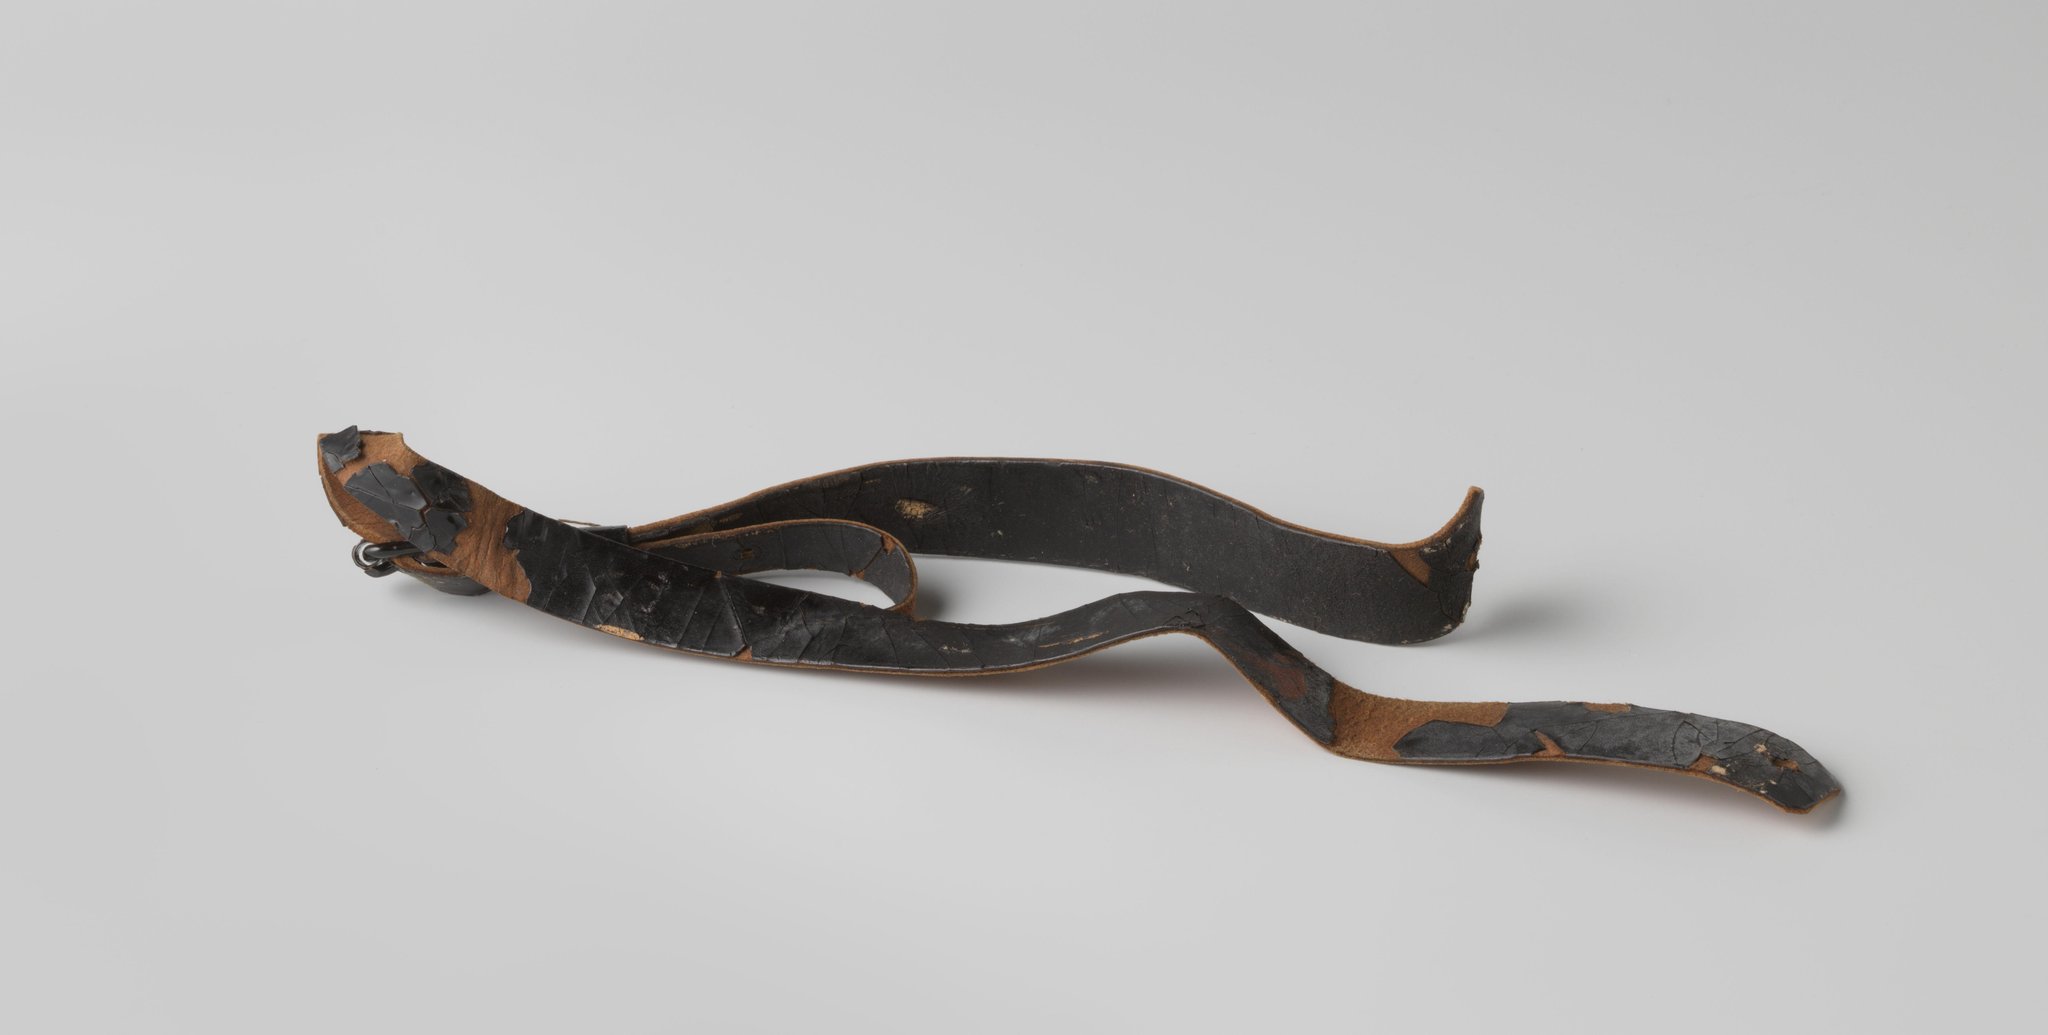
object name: uniform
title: Riem horende bij een sjako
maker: Anonymous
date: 1870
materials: leather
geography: great britain